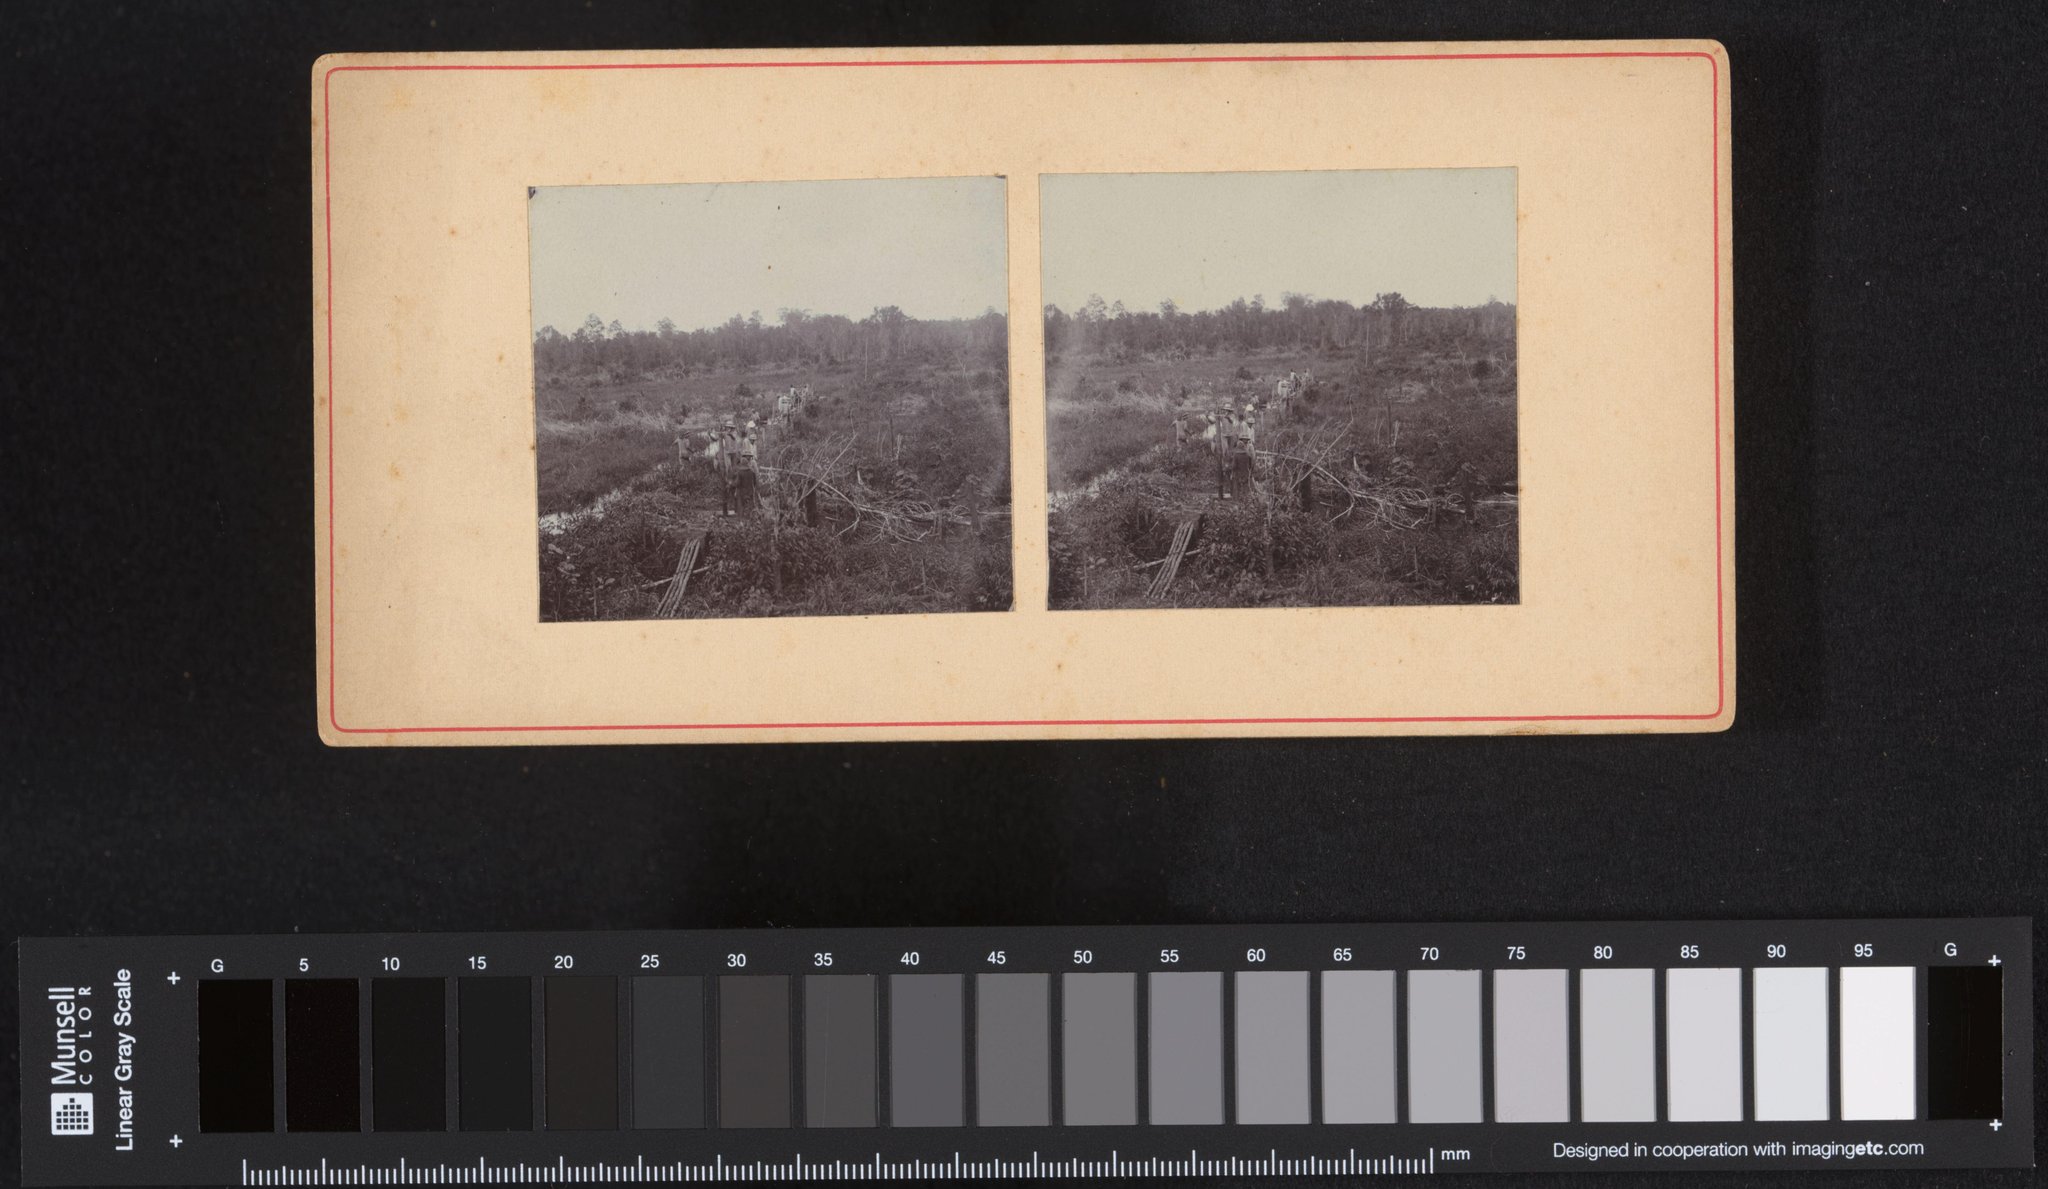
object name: stereograph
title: Werk in open terrein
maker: robert julius boers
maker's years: 1867-1932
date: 1900-1922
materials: cardboard, photographic support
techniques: gelatin silver print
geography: bangka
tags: robert julius boers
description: Werkzaamheden op een open ongerooid terrein op Banka. Onderdeel van een groep stereofoto's van Robert Julius Boers, chef van het staatsbedrijf de Banka-tinwinning op Banka, uit de periode ca. 1900-1922.